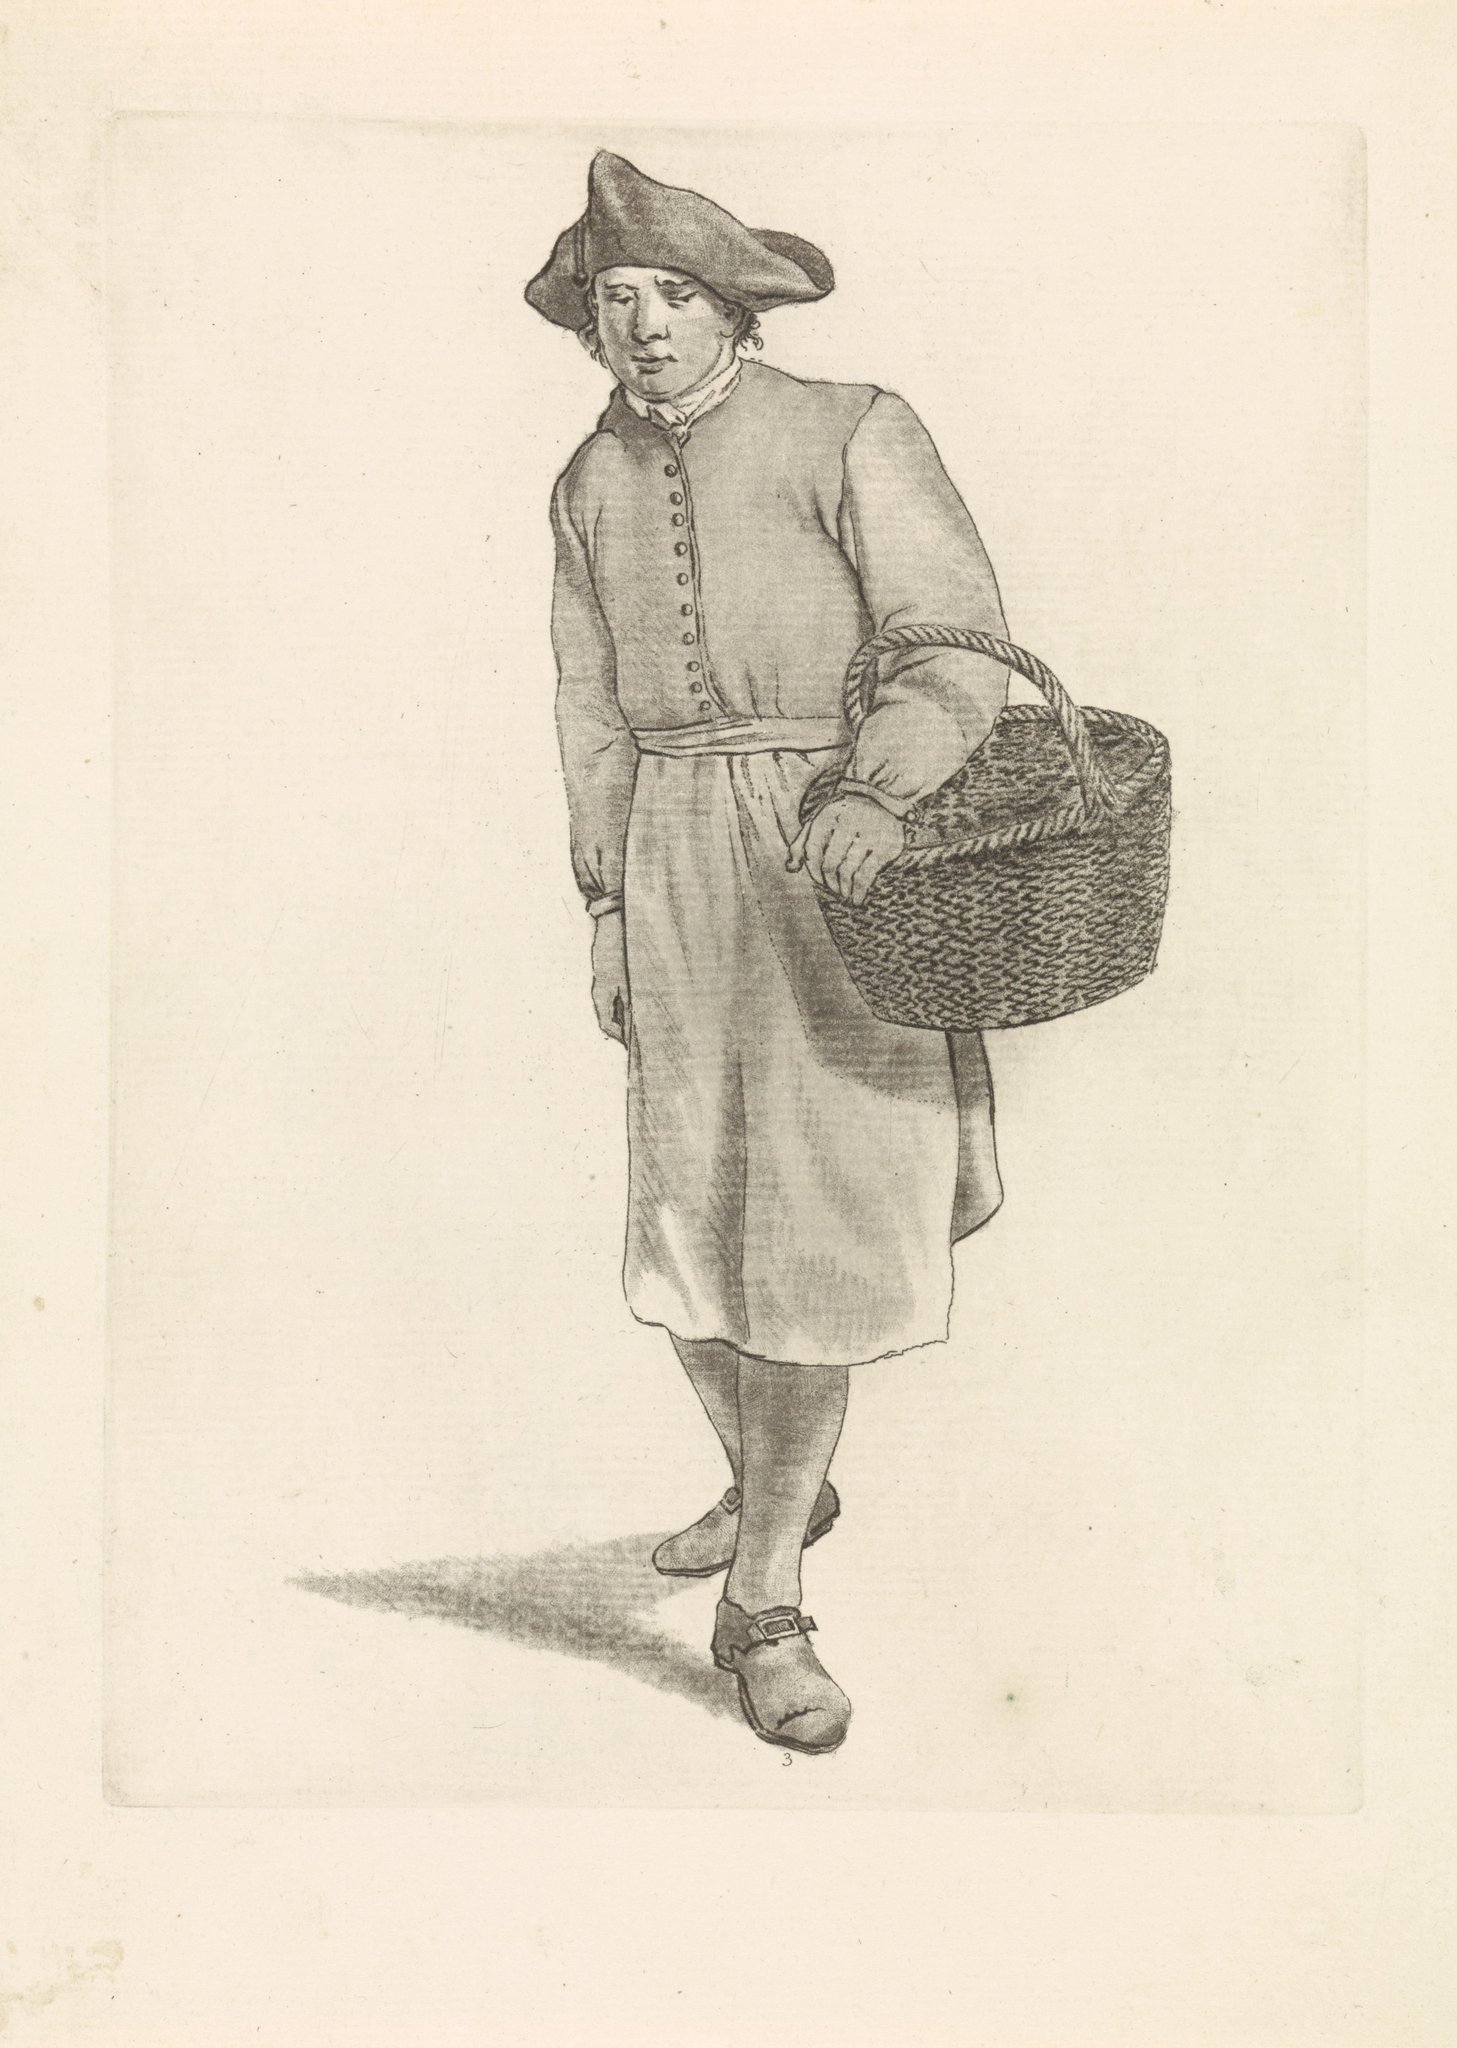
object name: print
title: Man met rieten mand aan de arm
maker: mathias de sallieth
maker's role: print maker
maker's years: 1749-1791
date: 1772-1791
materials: paper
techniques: aquatint, etching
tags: container made of plant material other than wood: basket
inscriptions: collector's mark: Lugt 2228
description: De prent verscheen vanaf 1818 tevens als onderdeel van een 33-delige reeks prenten door Mathias de Sallieth, samengebonden in: Perkois, Jacobus, Prins, Johannes Huibert. Verzameling van verschillende gekleede mans- en vrouwenstanden, ter oefening van jonge schilders en liefhebbers. Rotterdam: Johannes Immerzeel, 1818.